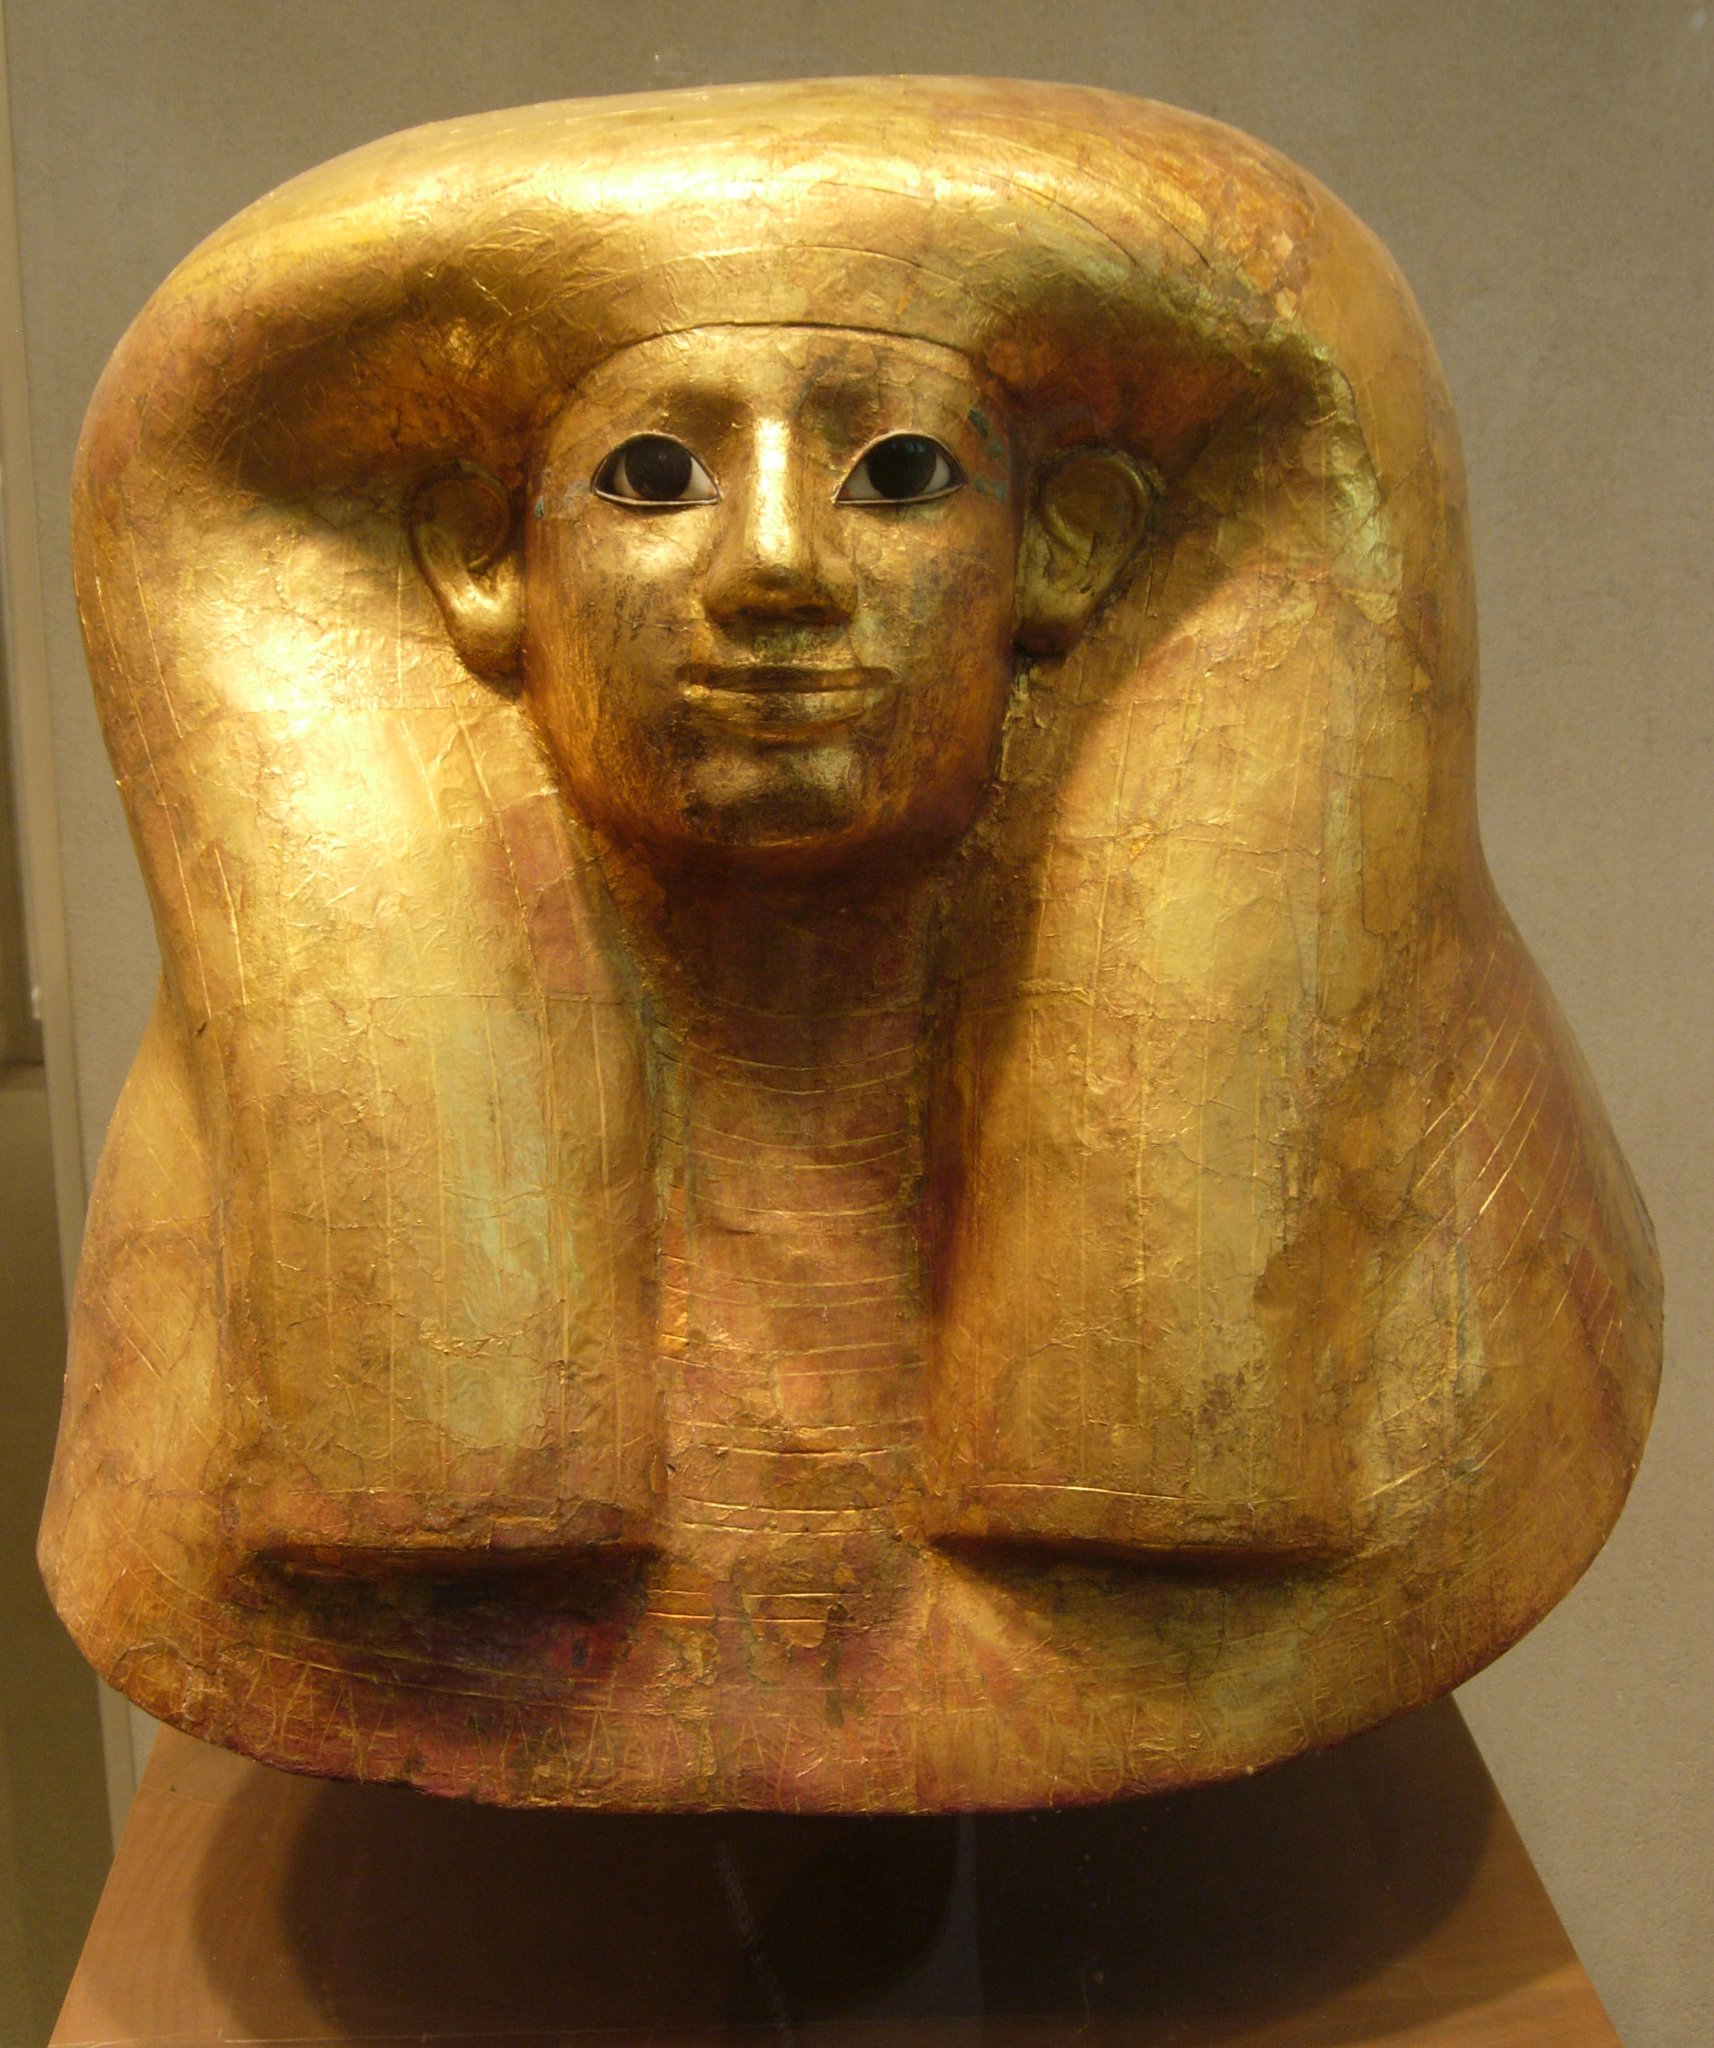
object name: mask, hatnefer, cartonnage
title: Funerary mask of Hatnefer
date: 1492-1473 BCE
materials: wood, gold, obsidian, stone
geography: egypt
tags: masks